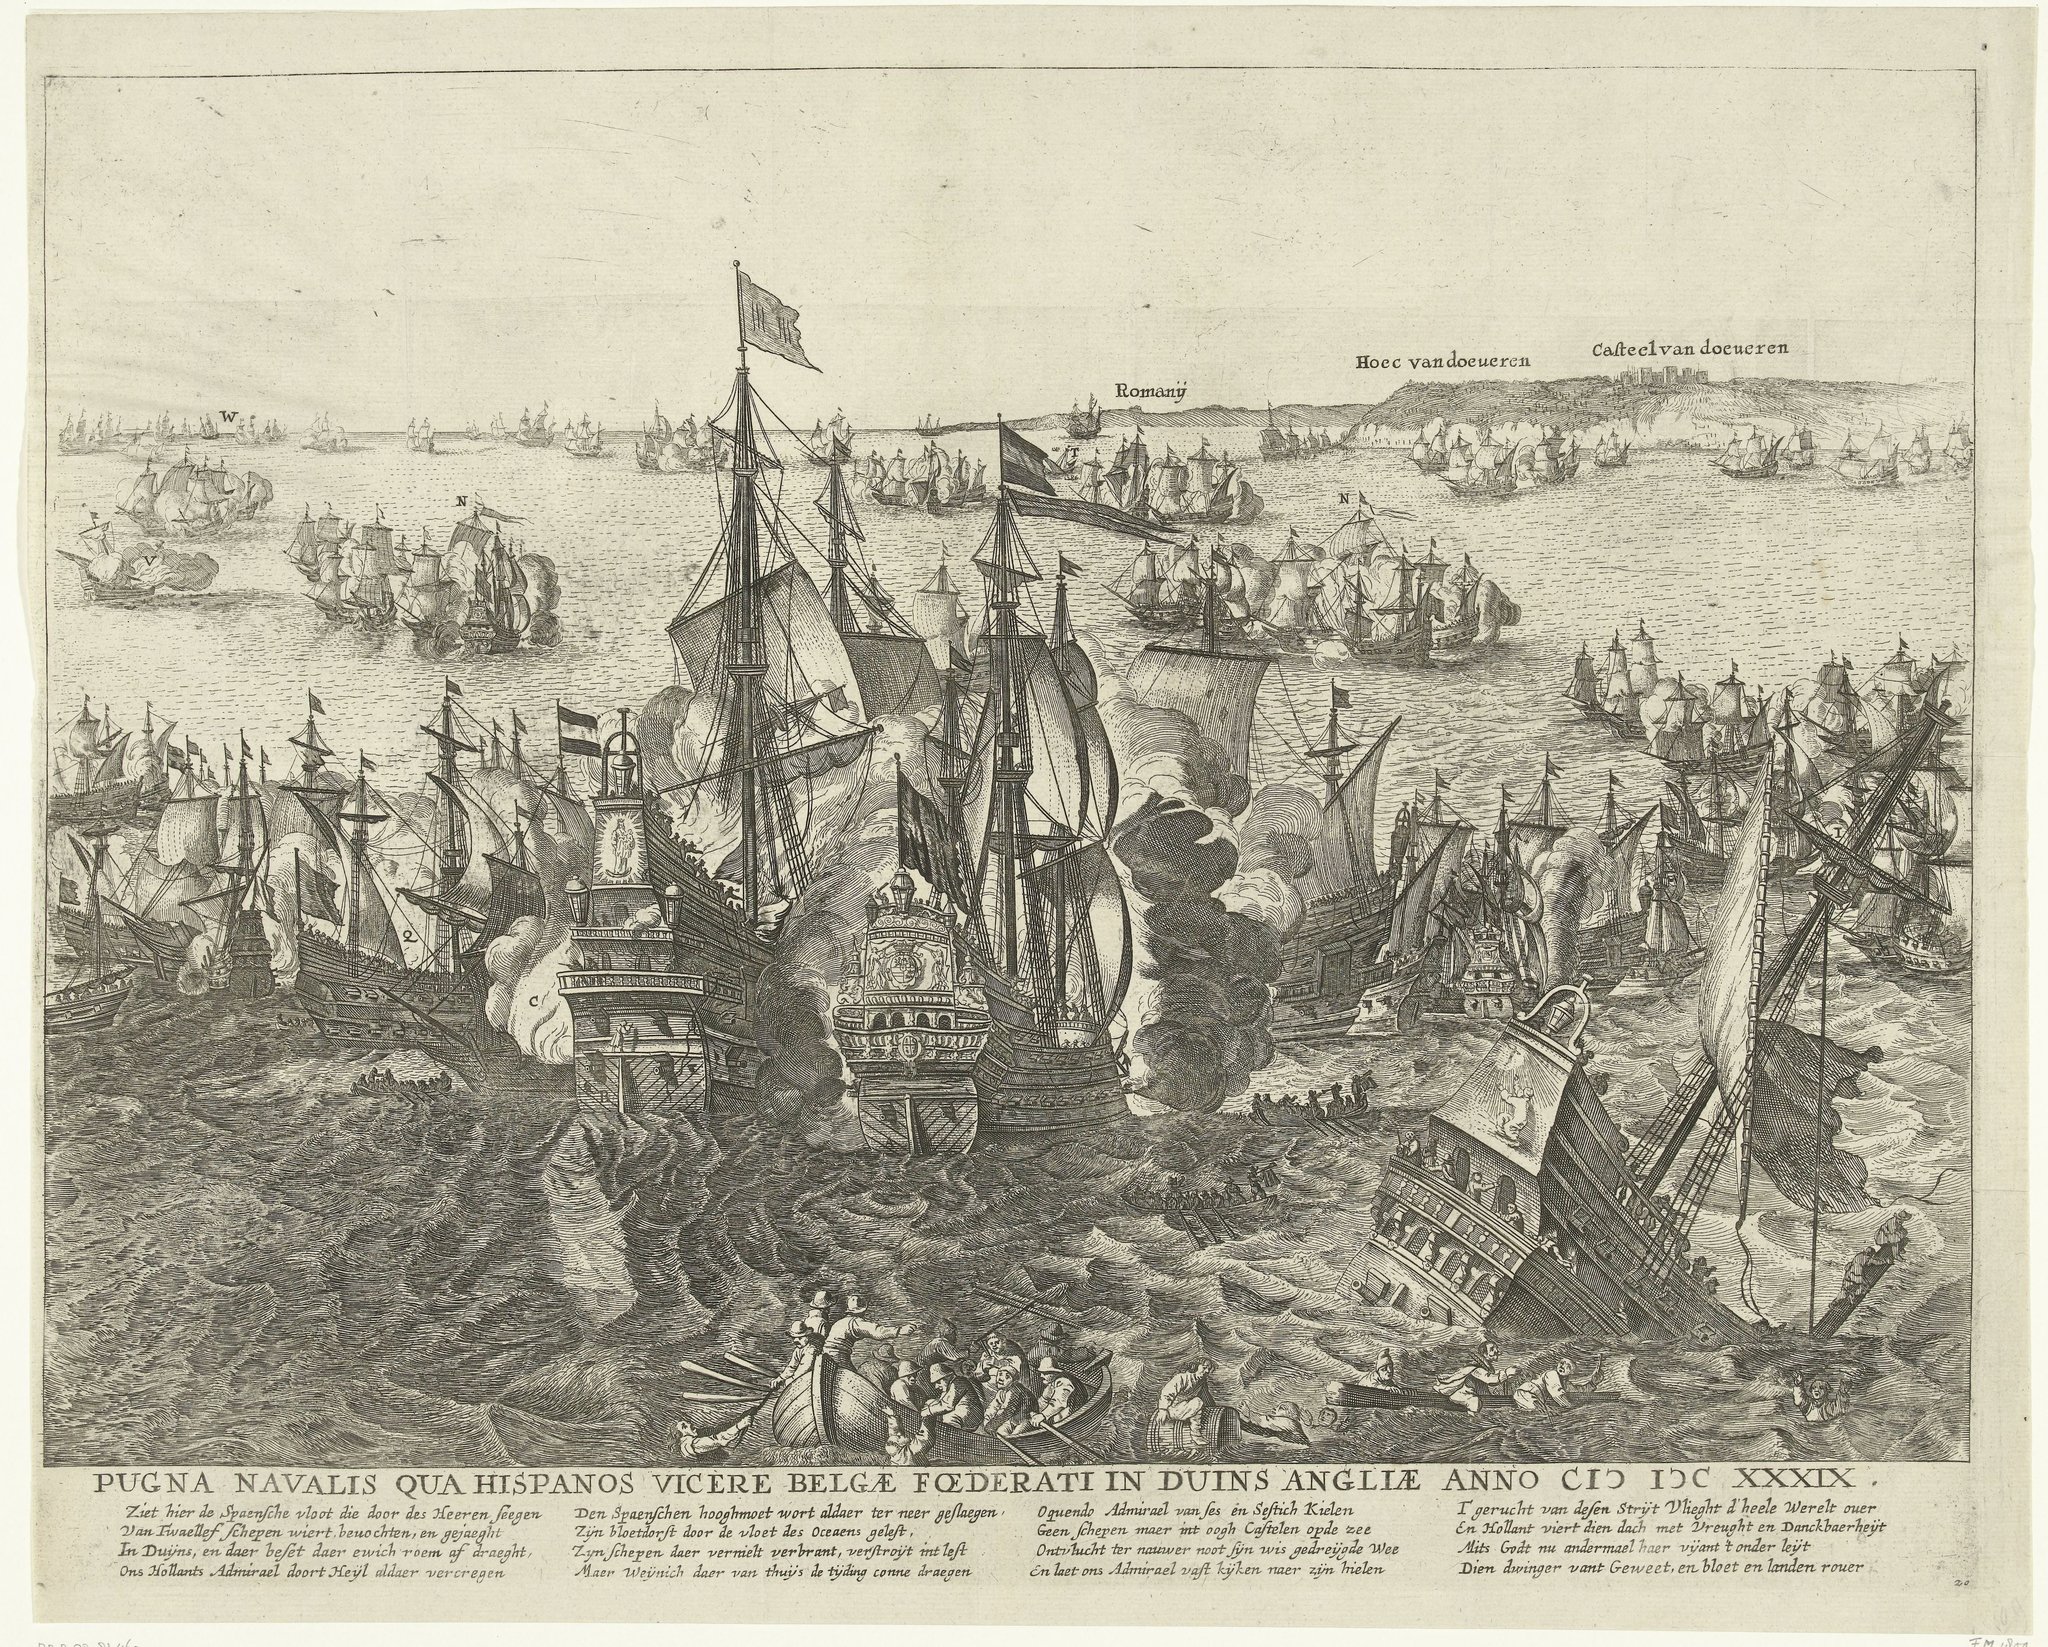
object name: print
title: De zeeslag bij Duins, 1639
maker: Anonymous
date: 1640-1674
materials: paper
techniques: etching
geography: northern netherlands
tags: brielle, maarten harpertszoon tromp, battle (+ naval force), battle of the downs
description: De zeeslag bij Duins tussen de Spaanse vloot onder bevel van Antonio de Oquendo en de Staatse vloot onder Maarten Harpertsz. Tromp, 21 oktober 1639. Centraal de Spaanse en de Nederlandse admiraalsschepen de Santa Teresa en de Aemilia. Rechts het zinken van de St. Francisco. Op de voorgrond drenkelingen in het water en in een sloep, op de achtergrond de Engelse kust tussen Romney en Dover. Met Latijnse titel en onderschrift van 4 verzen van 4 regels in het Nederlands. Gemerkt rechtsonder: 20.